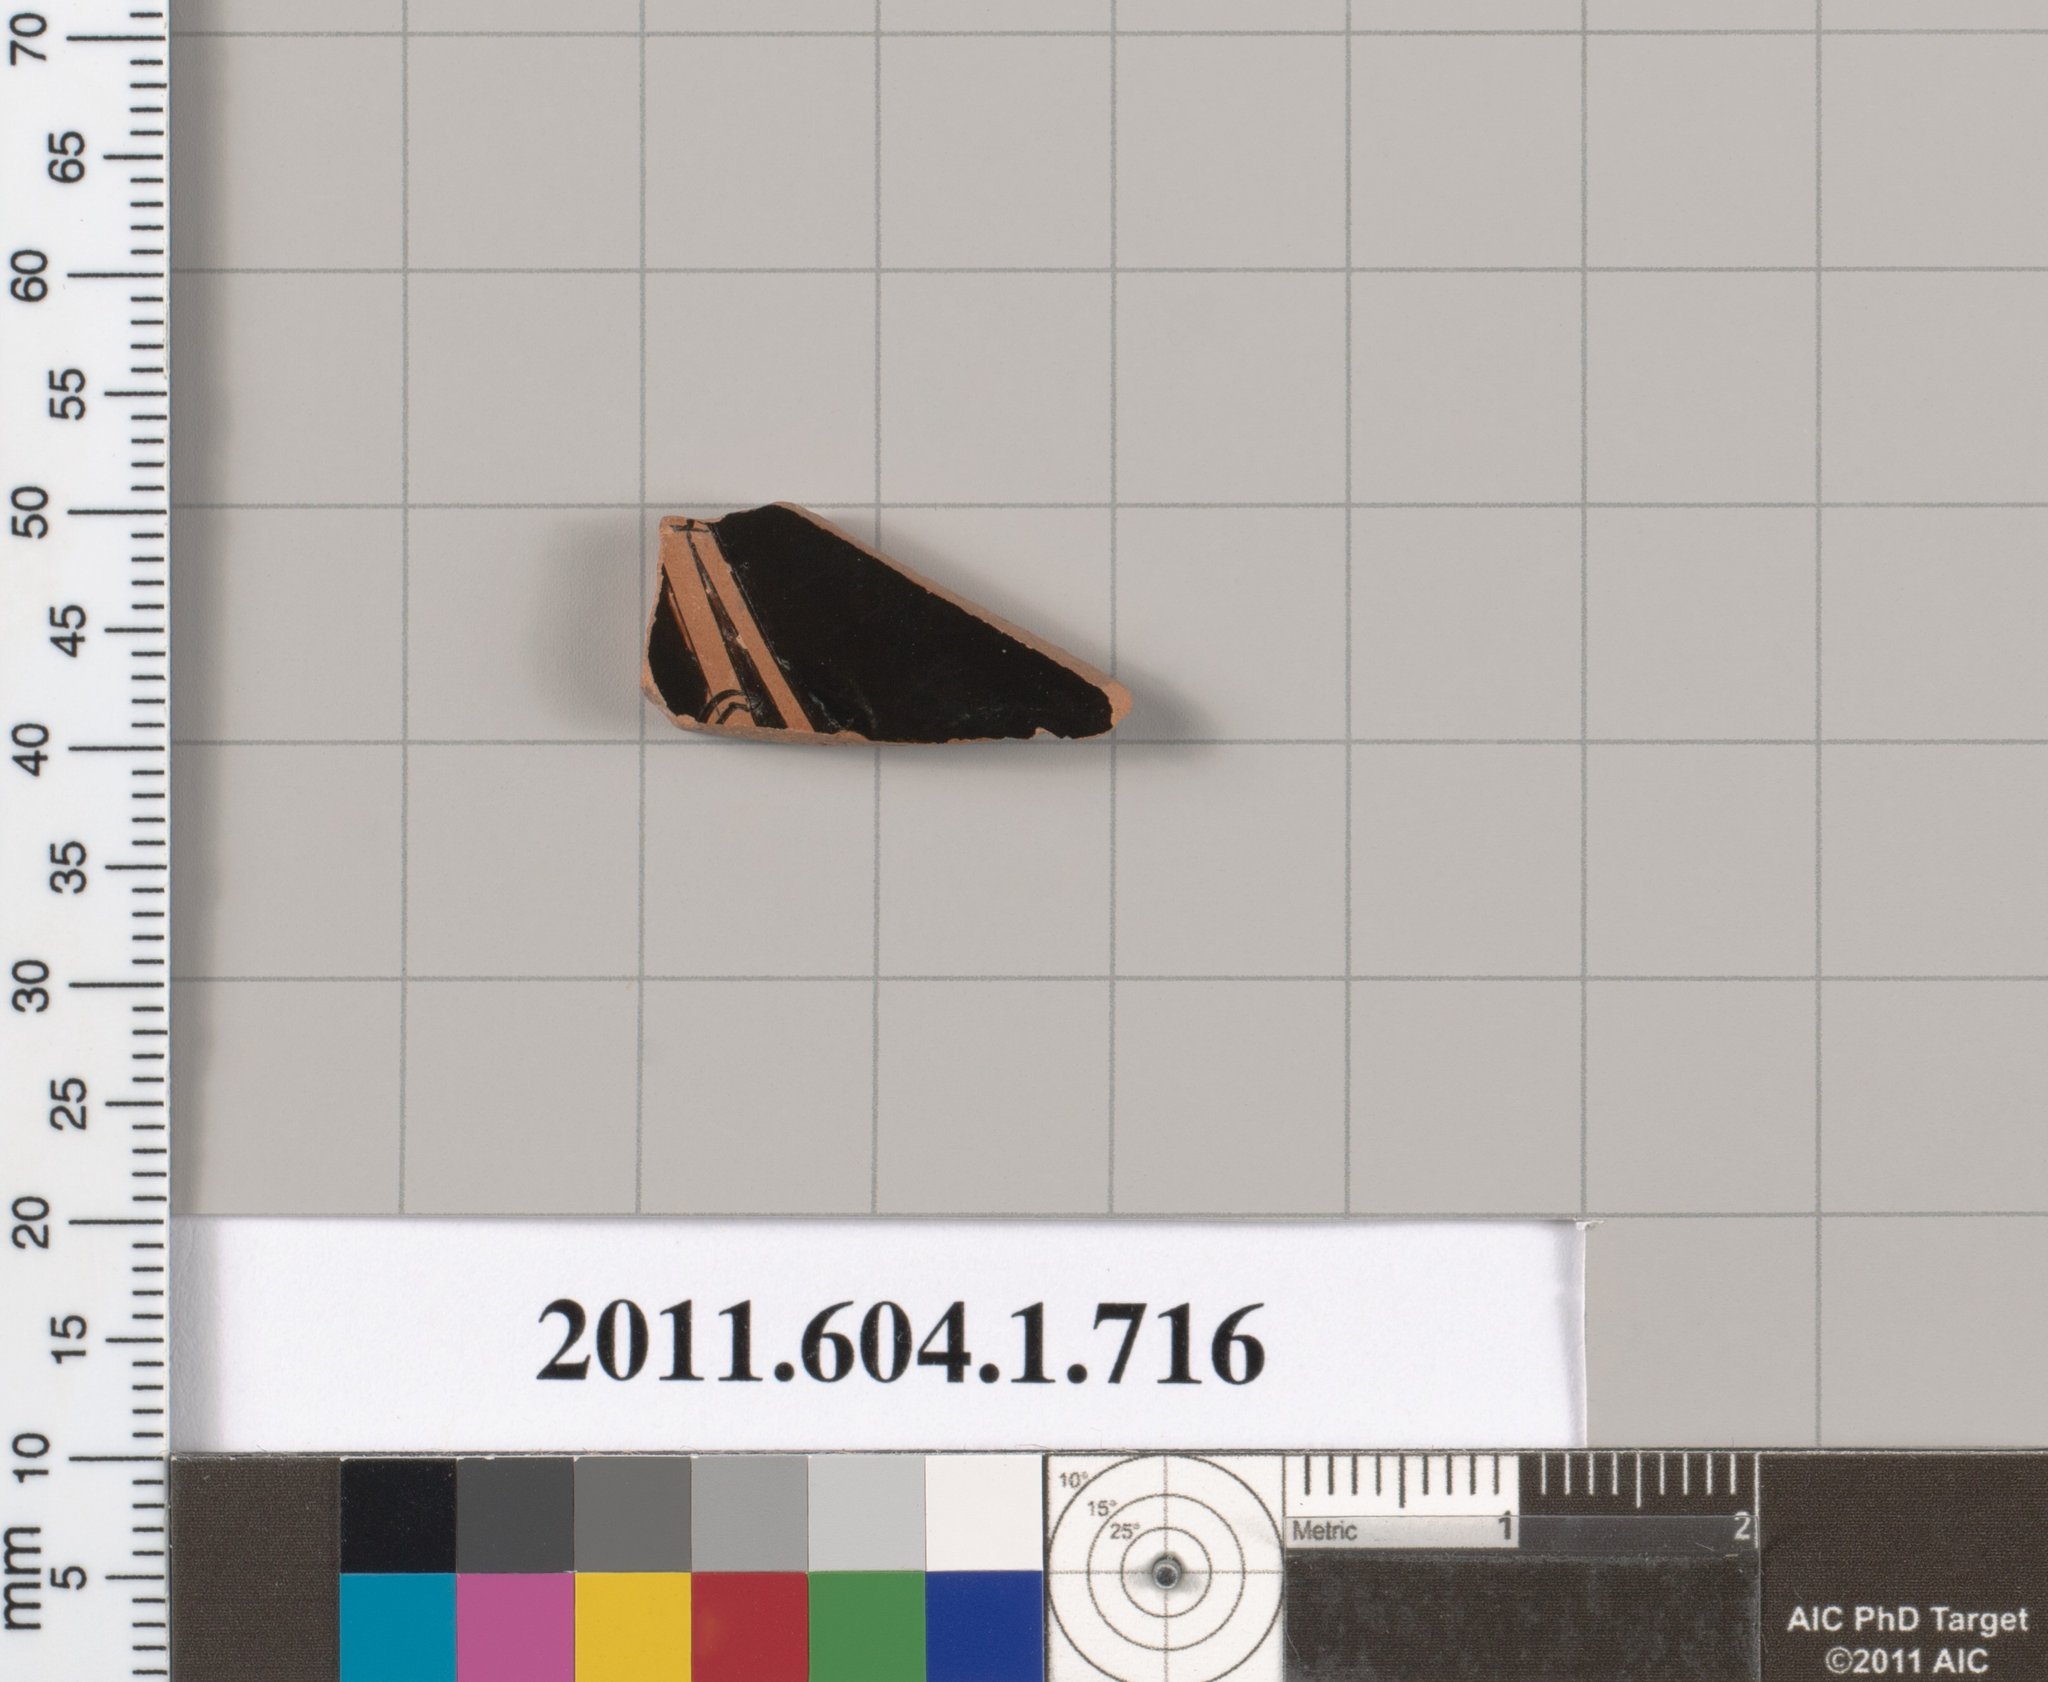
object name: kylix fragment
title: Terracotta fragment of a kylix (drinking cup)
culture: greek, attic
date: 475-451 BCE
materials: terracotta